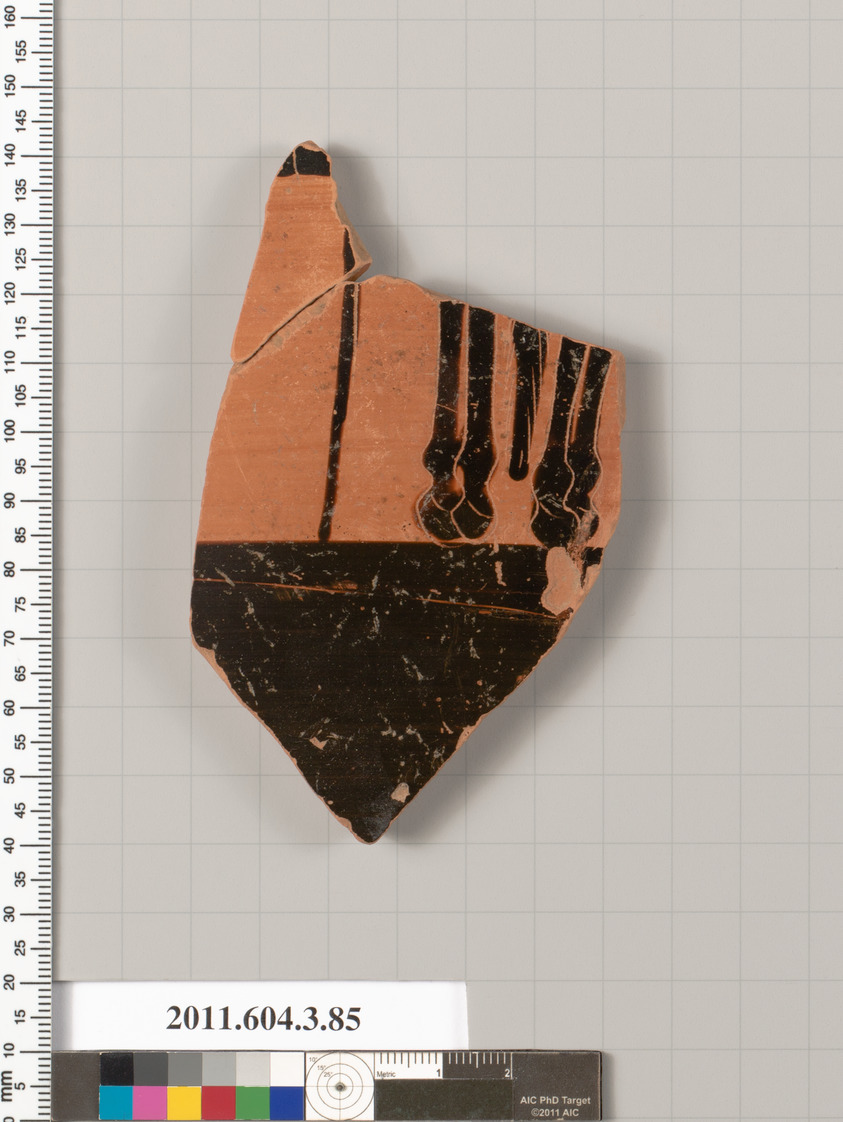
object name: amphora fragment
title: Terracotta fragment of an amphora (jar)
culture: greek, attic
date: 534-501 BCE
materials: terracotta